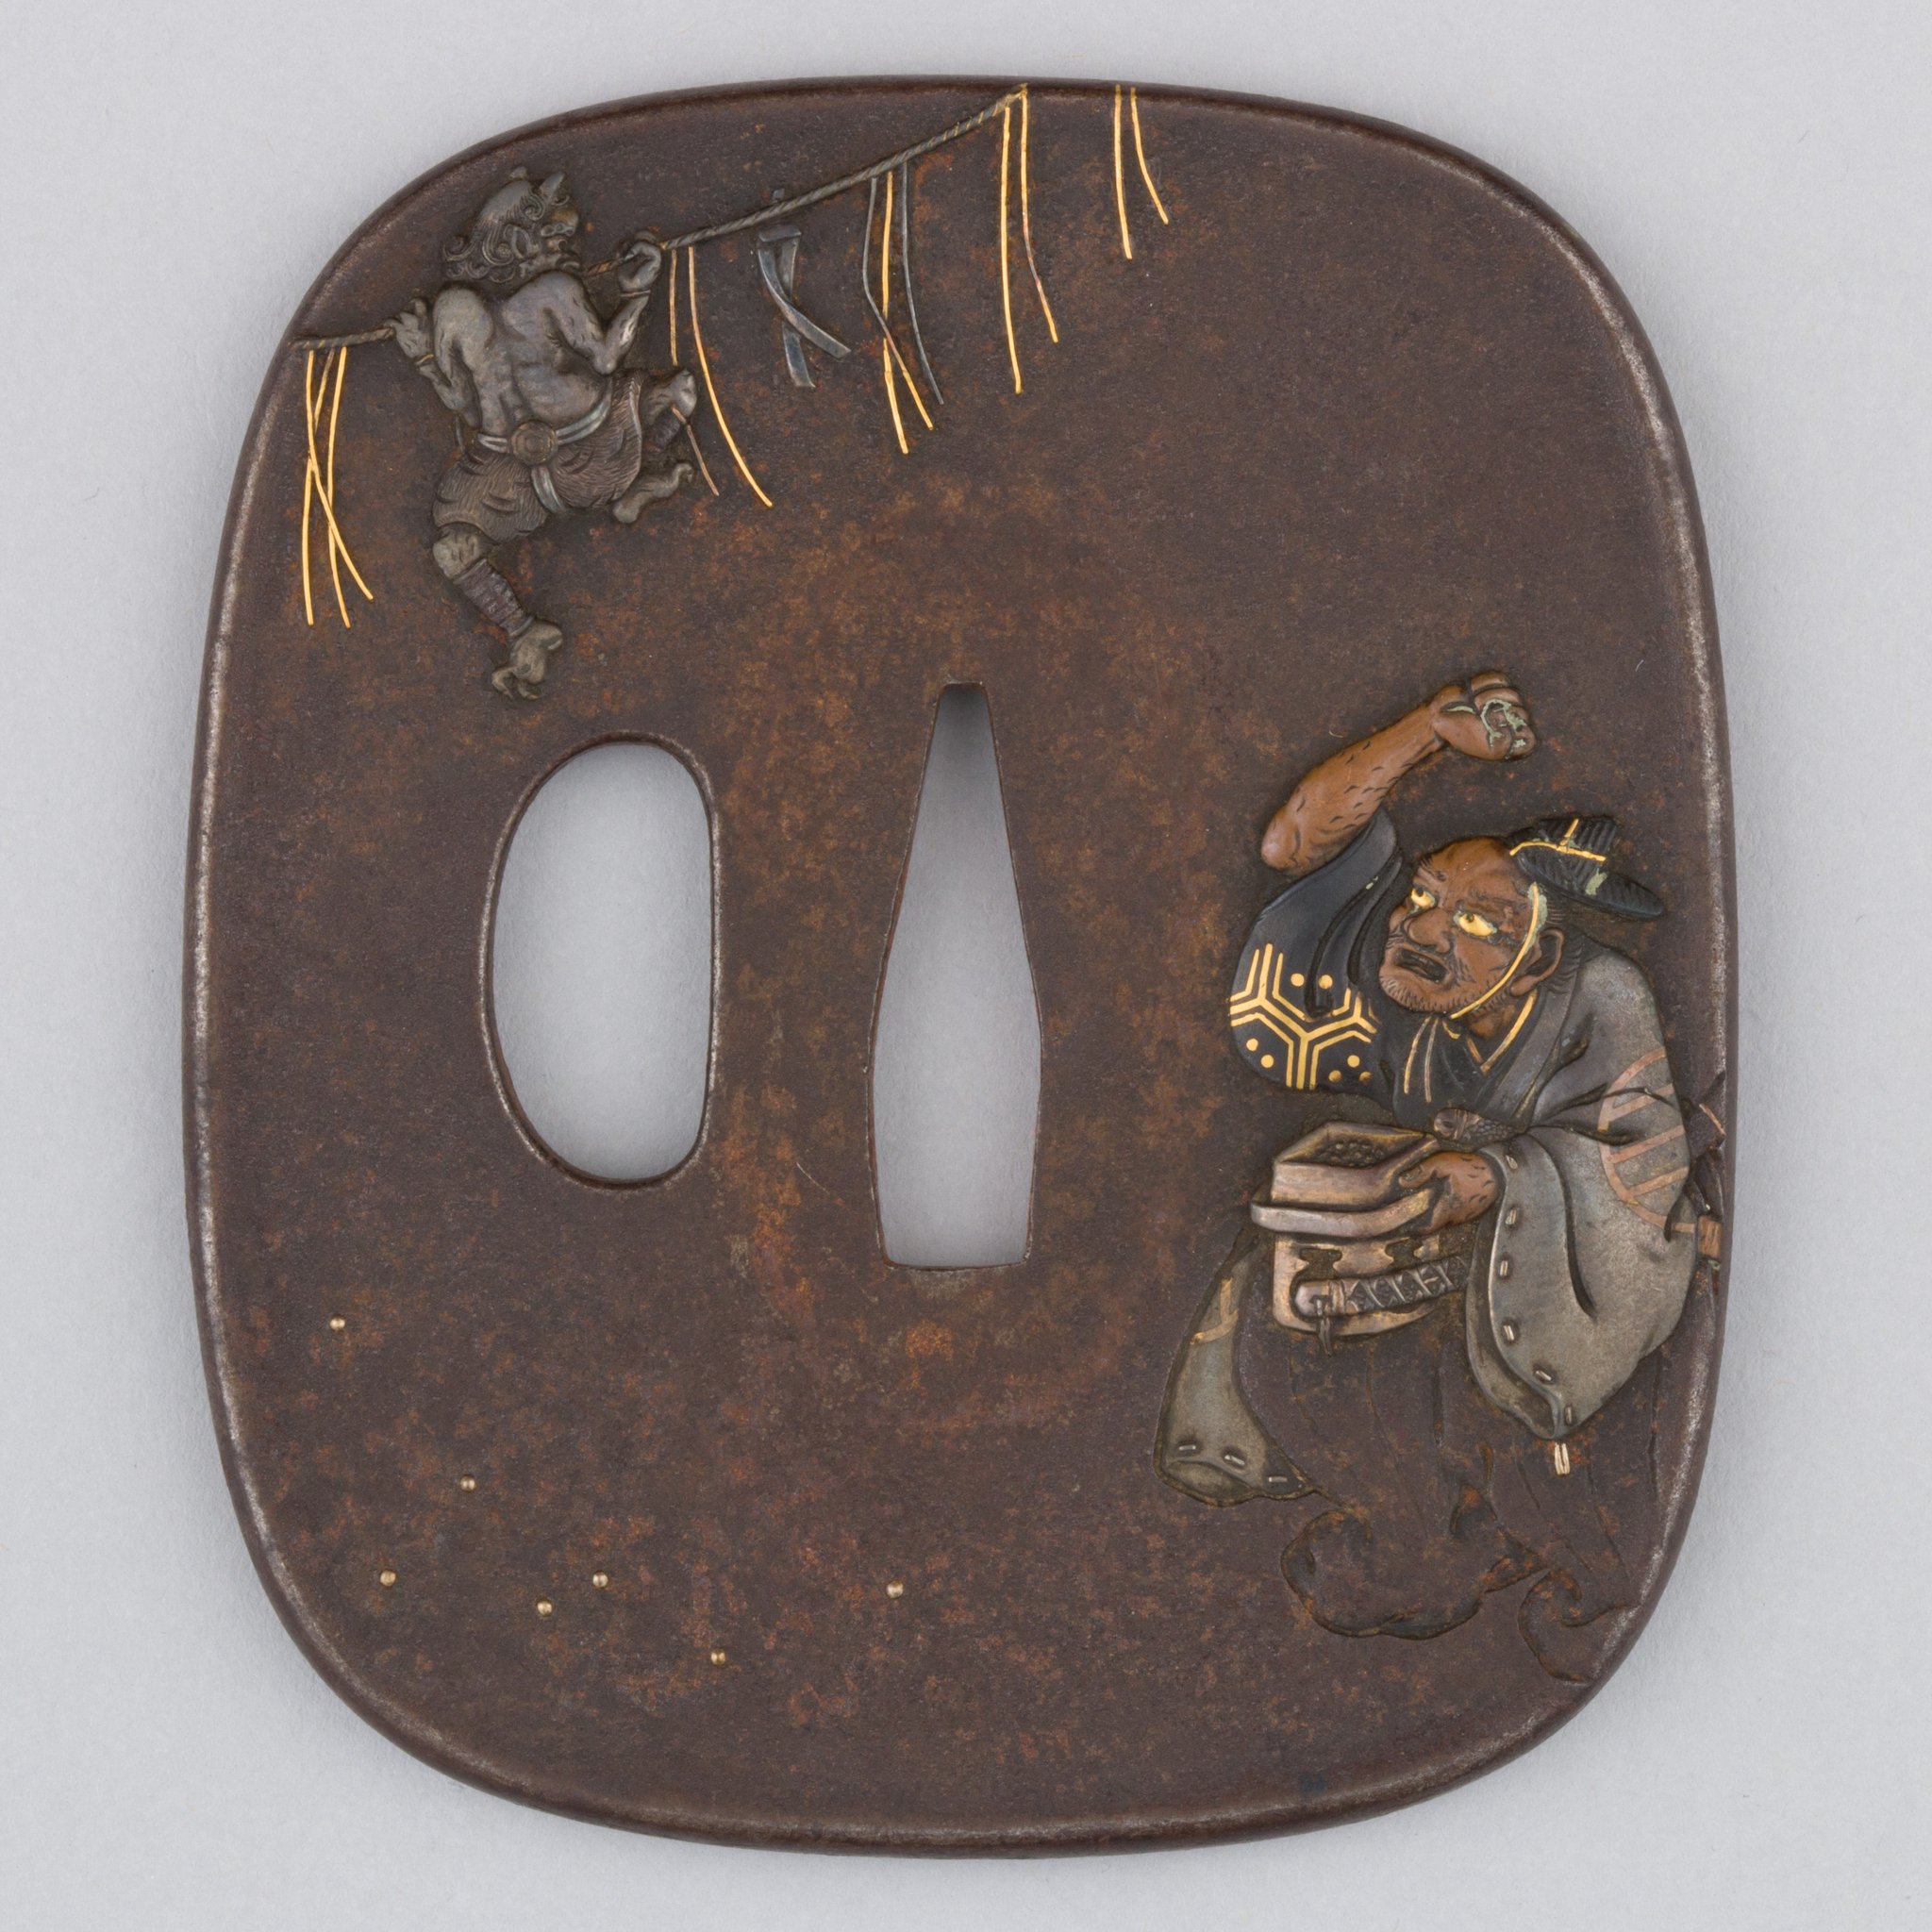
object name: sword guard tsuba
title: Sword Guard (Tsuba)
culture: japanese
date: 1615-1868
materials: copper, gold alloy, gold, iron, silver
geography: japan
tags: men